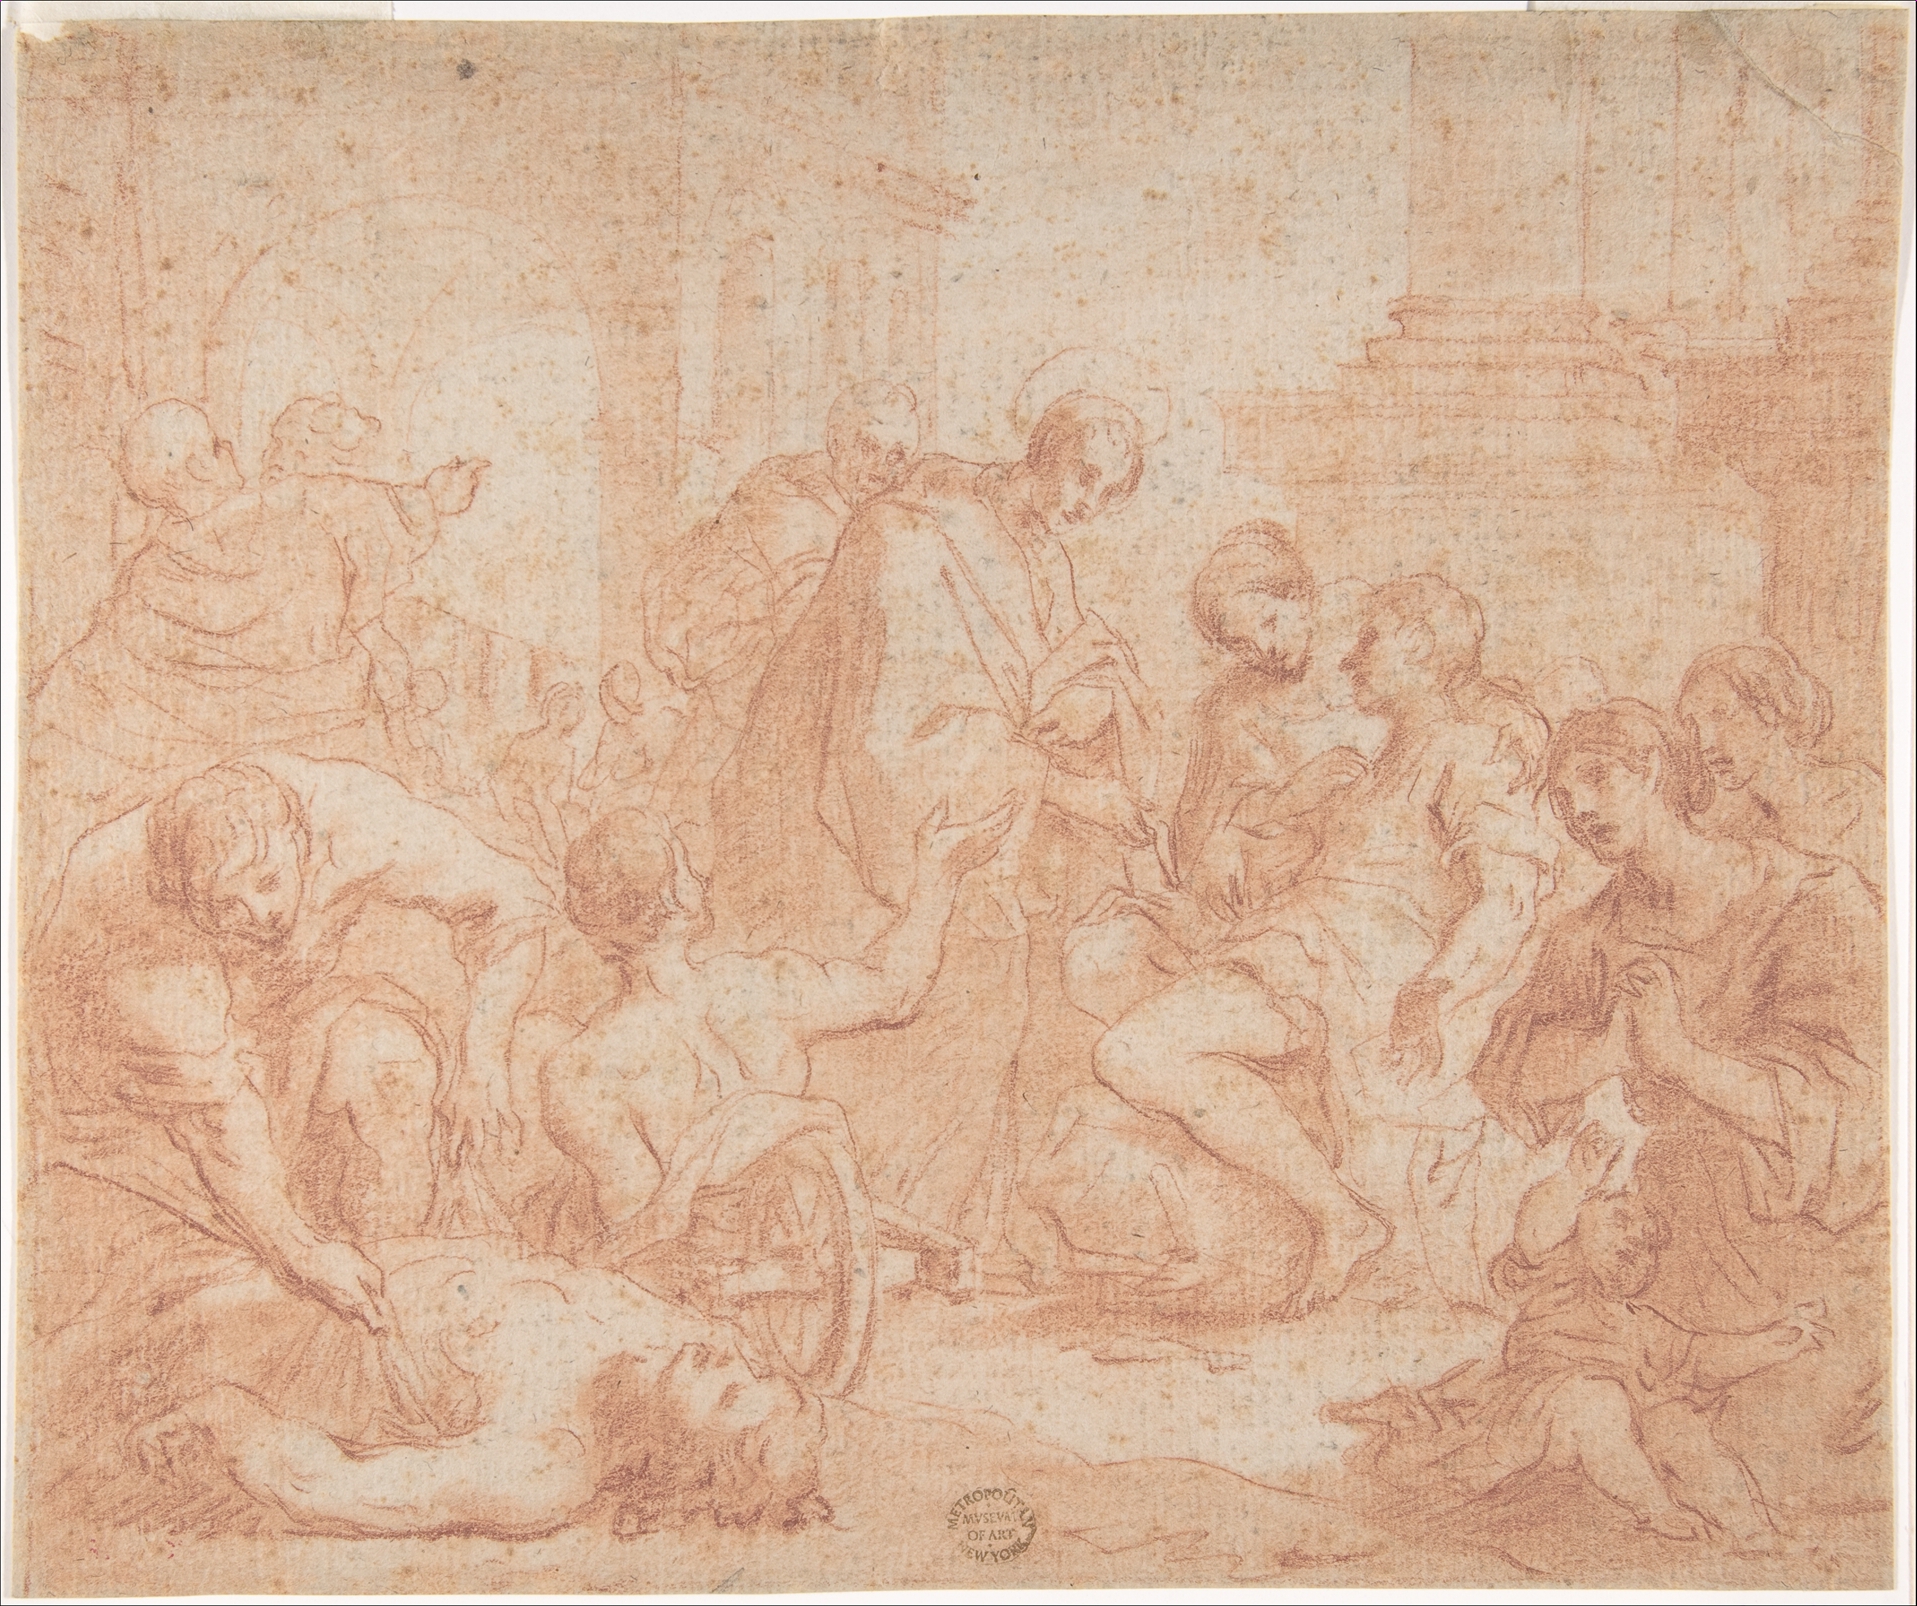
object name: drawing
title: A Saint Healing the Sick (recto); Upper Body of Nude Male with Outstretched Arms, seen from the rear (verso)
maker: anonymous, italian, roman-bolognese, 17th century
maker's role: artist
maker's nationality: italian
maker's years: 1600-1700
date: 1601-1700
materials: chalk, paper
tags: men,male nudes,women,saints